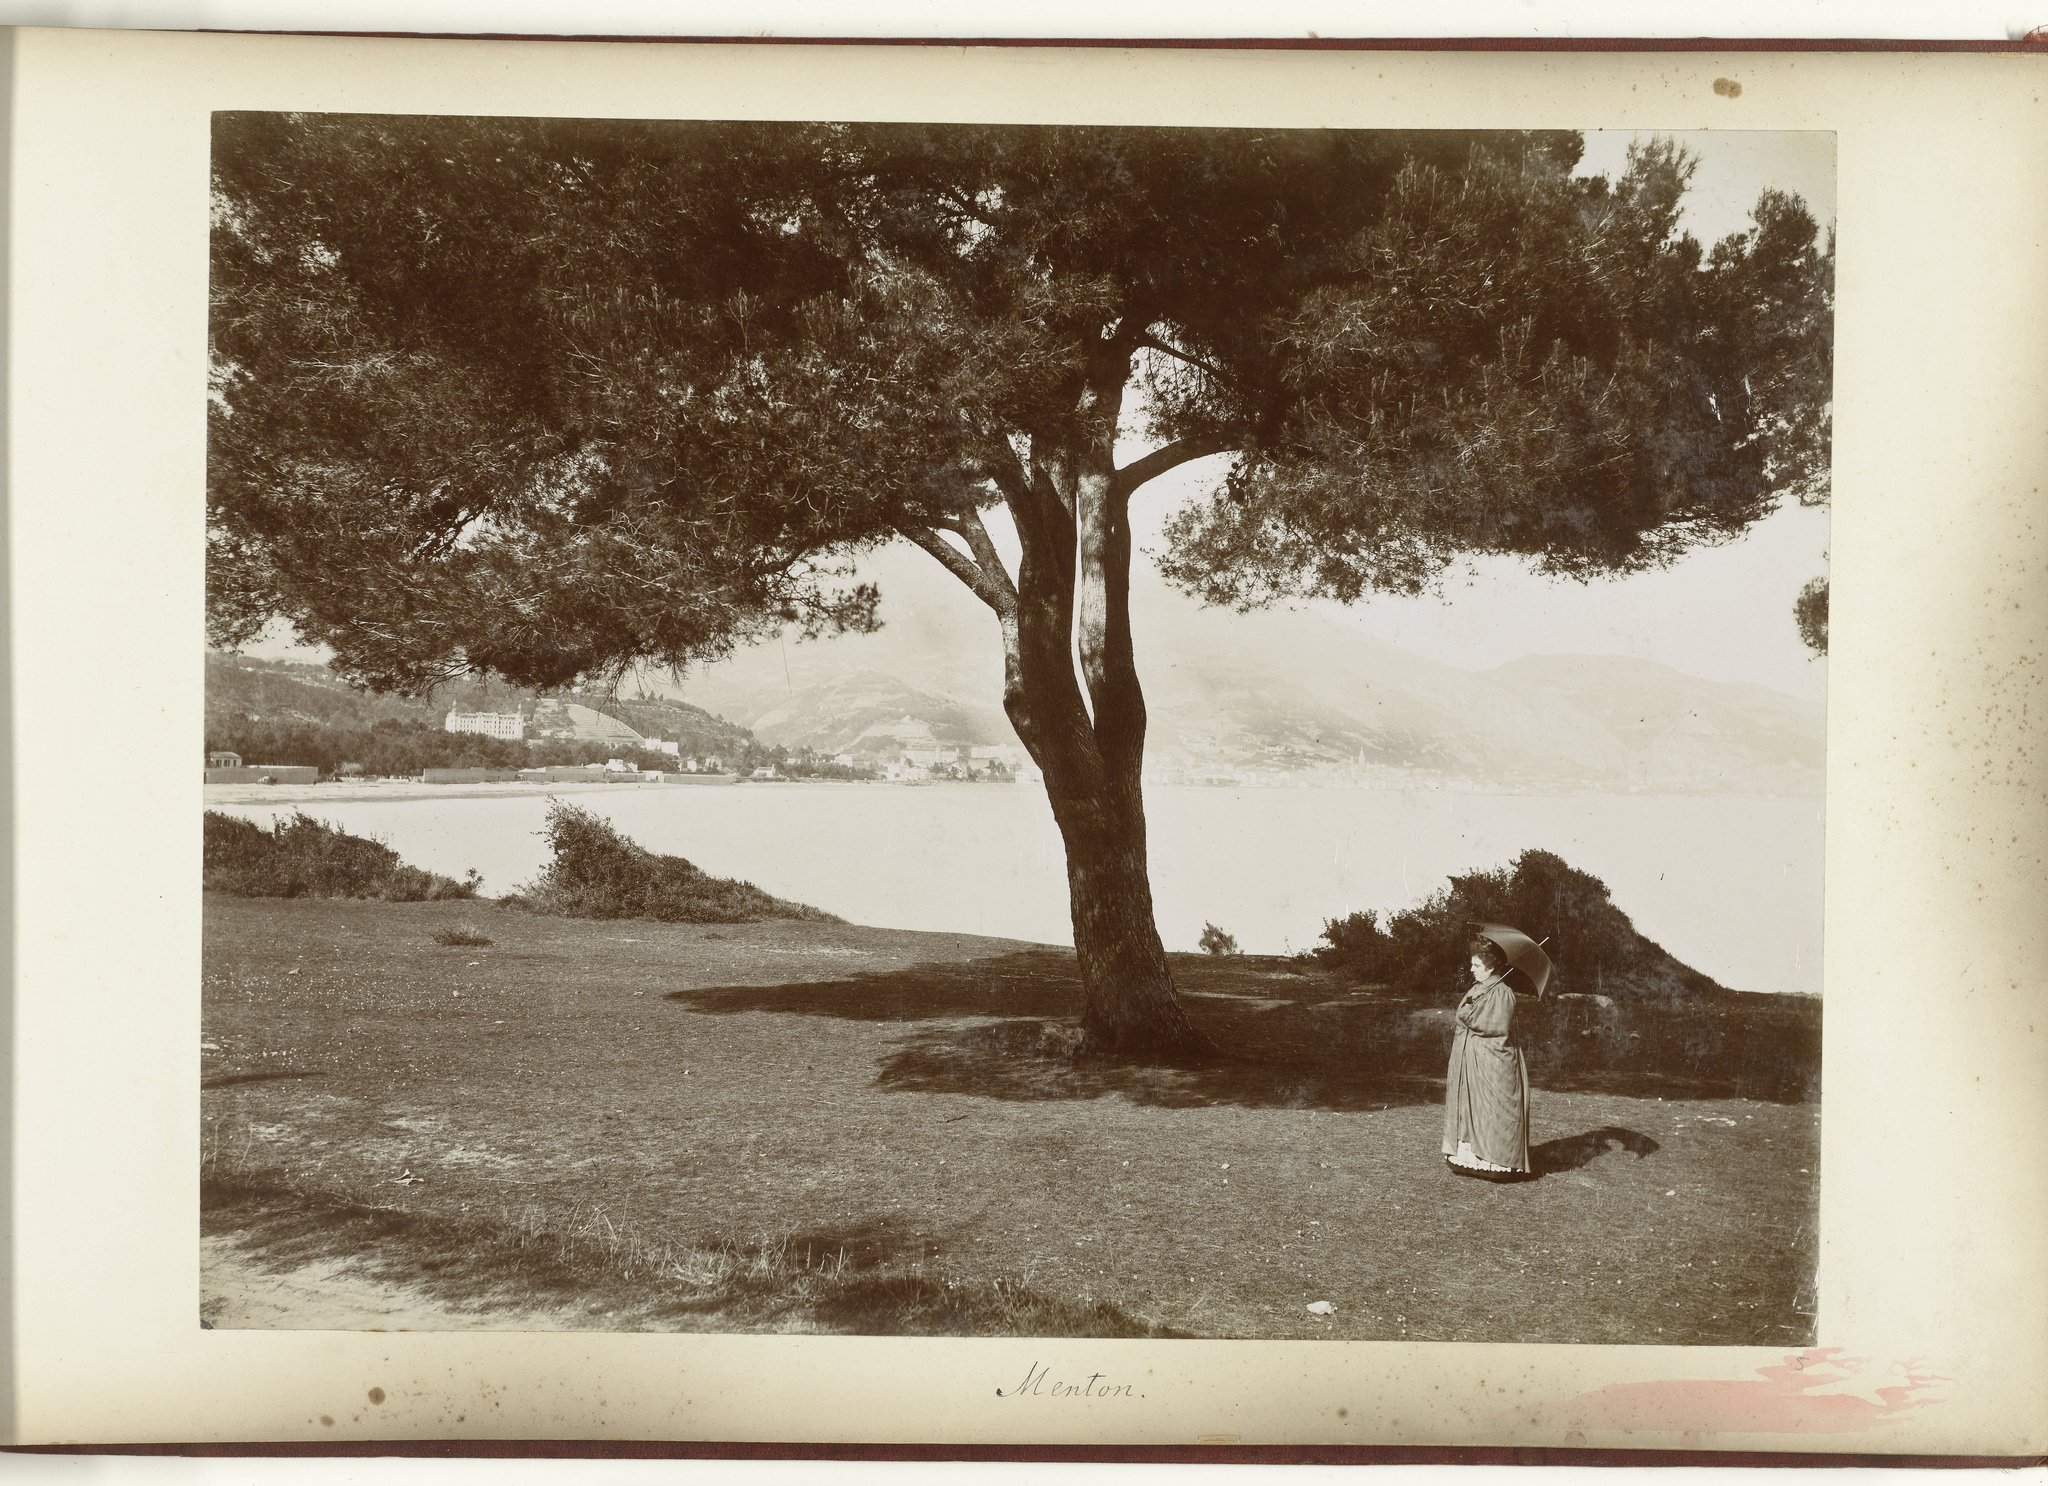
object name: photograph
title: Menton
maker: henry pauw van wieldrecht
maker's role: fotograaf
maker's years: 1863-1912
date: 1886-1896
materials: cardboard, photographic support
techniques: albumen print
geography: france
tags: france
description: Uitzicht op de kuststrook van Menton met op het grasveld op de voorgrond een grote boom en een dame met parasol.